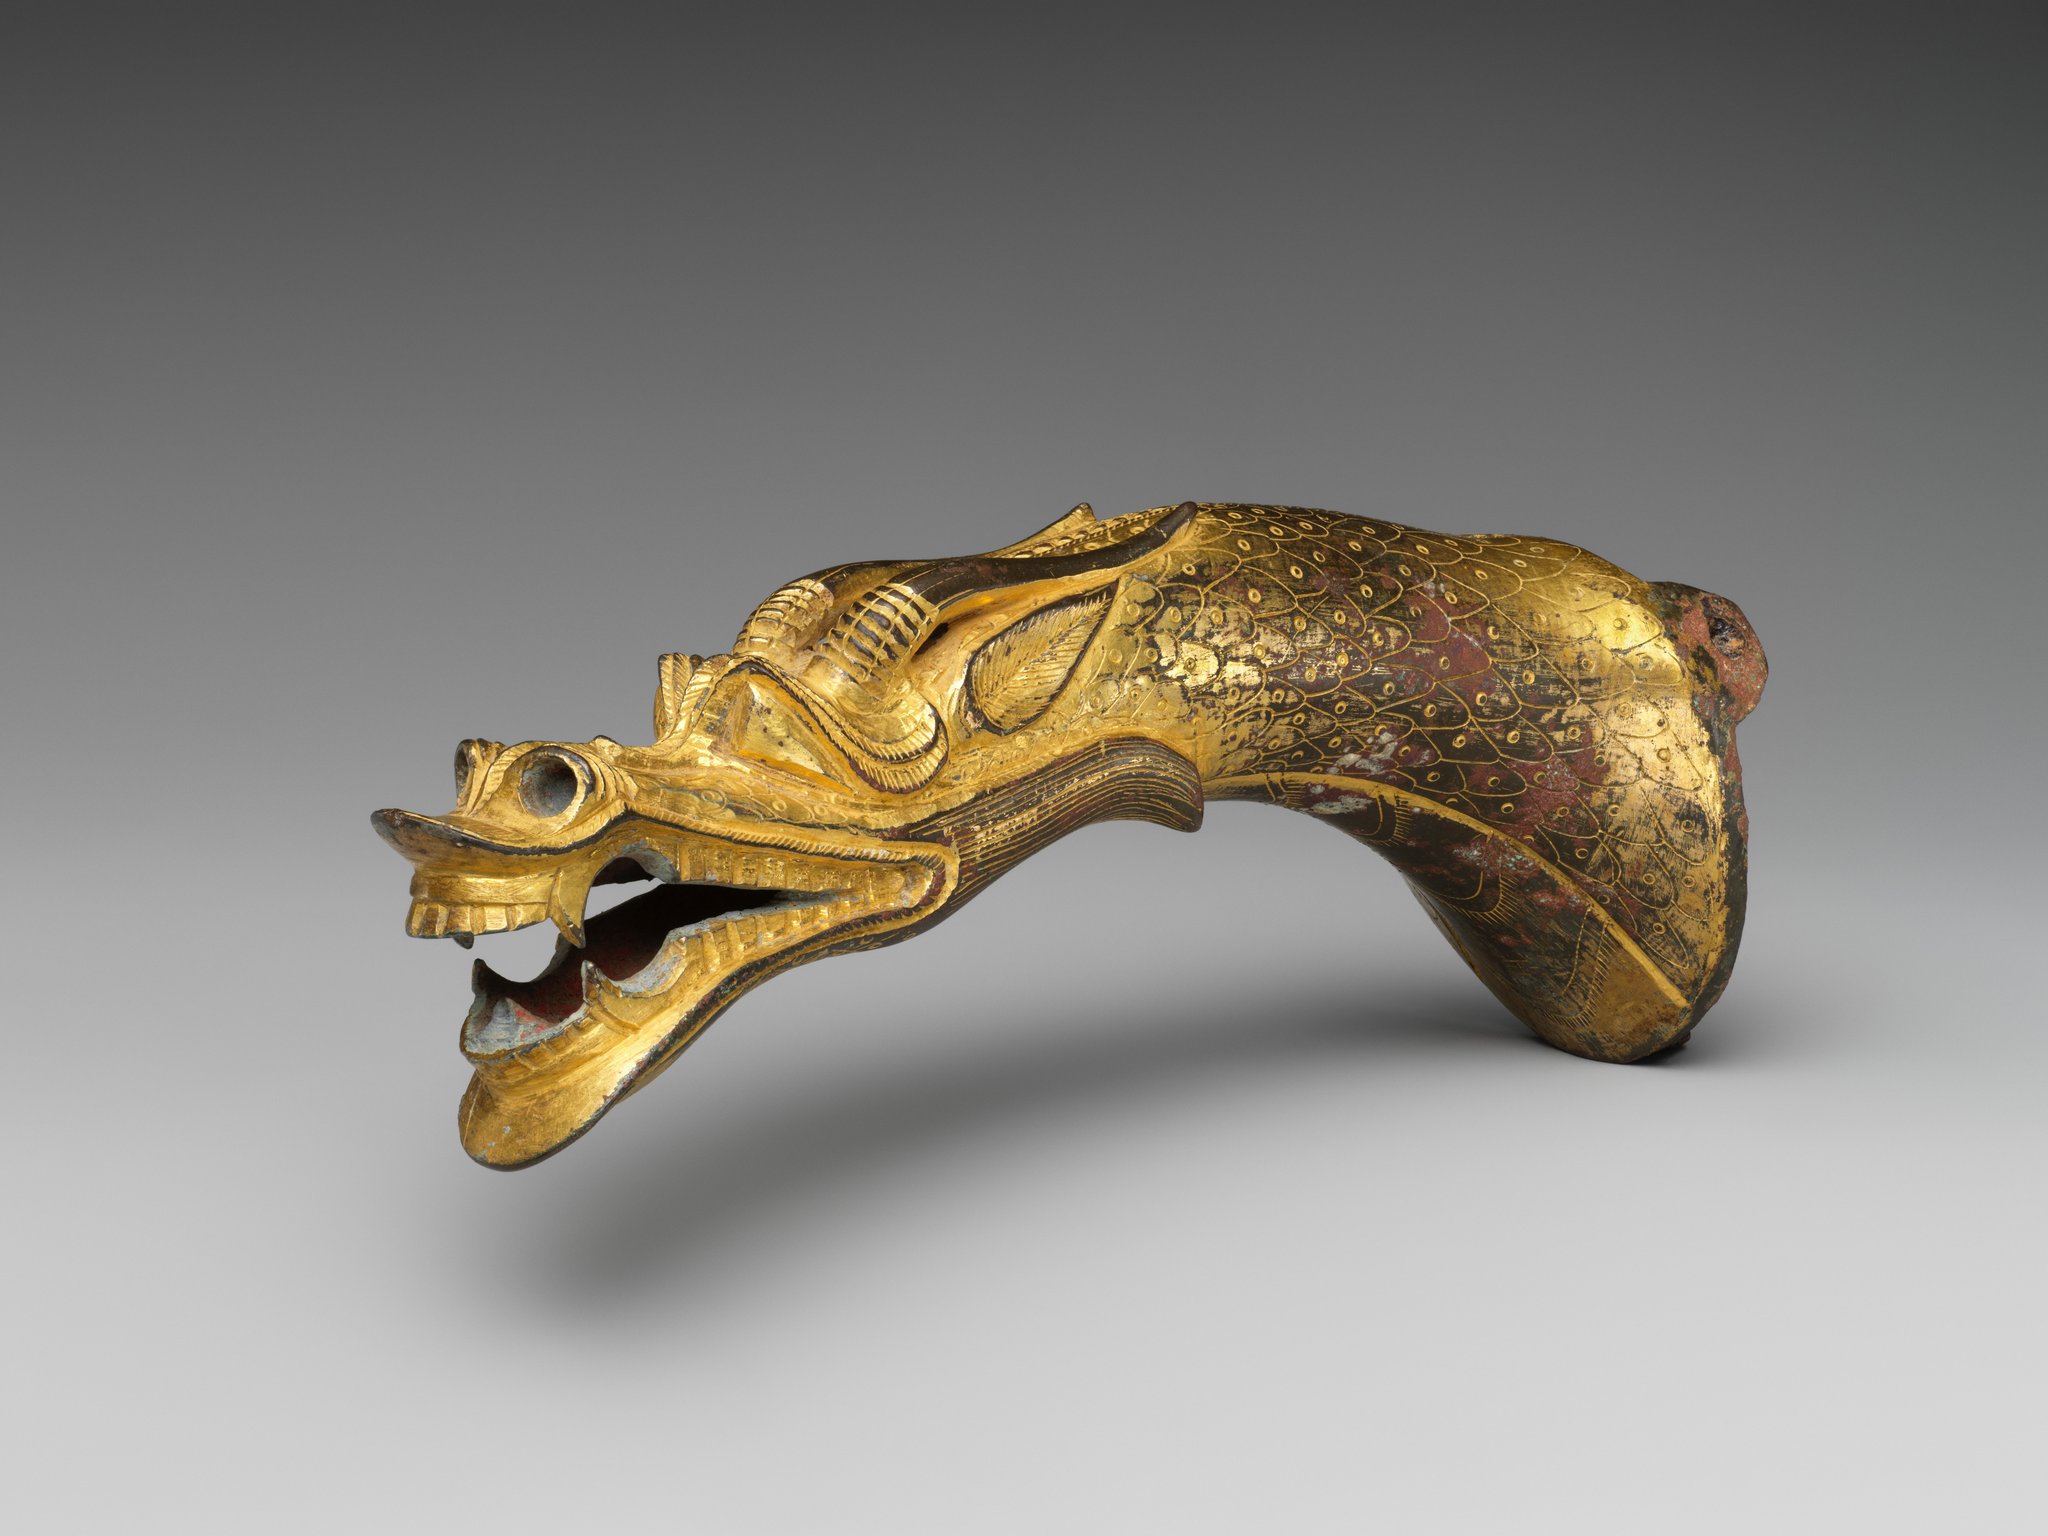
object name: finial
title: Finial in the shape of a dragon head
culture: chinese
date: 100 BCE-200 CE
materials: gilt bronze, pigment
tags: dragons